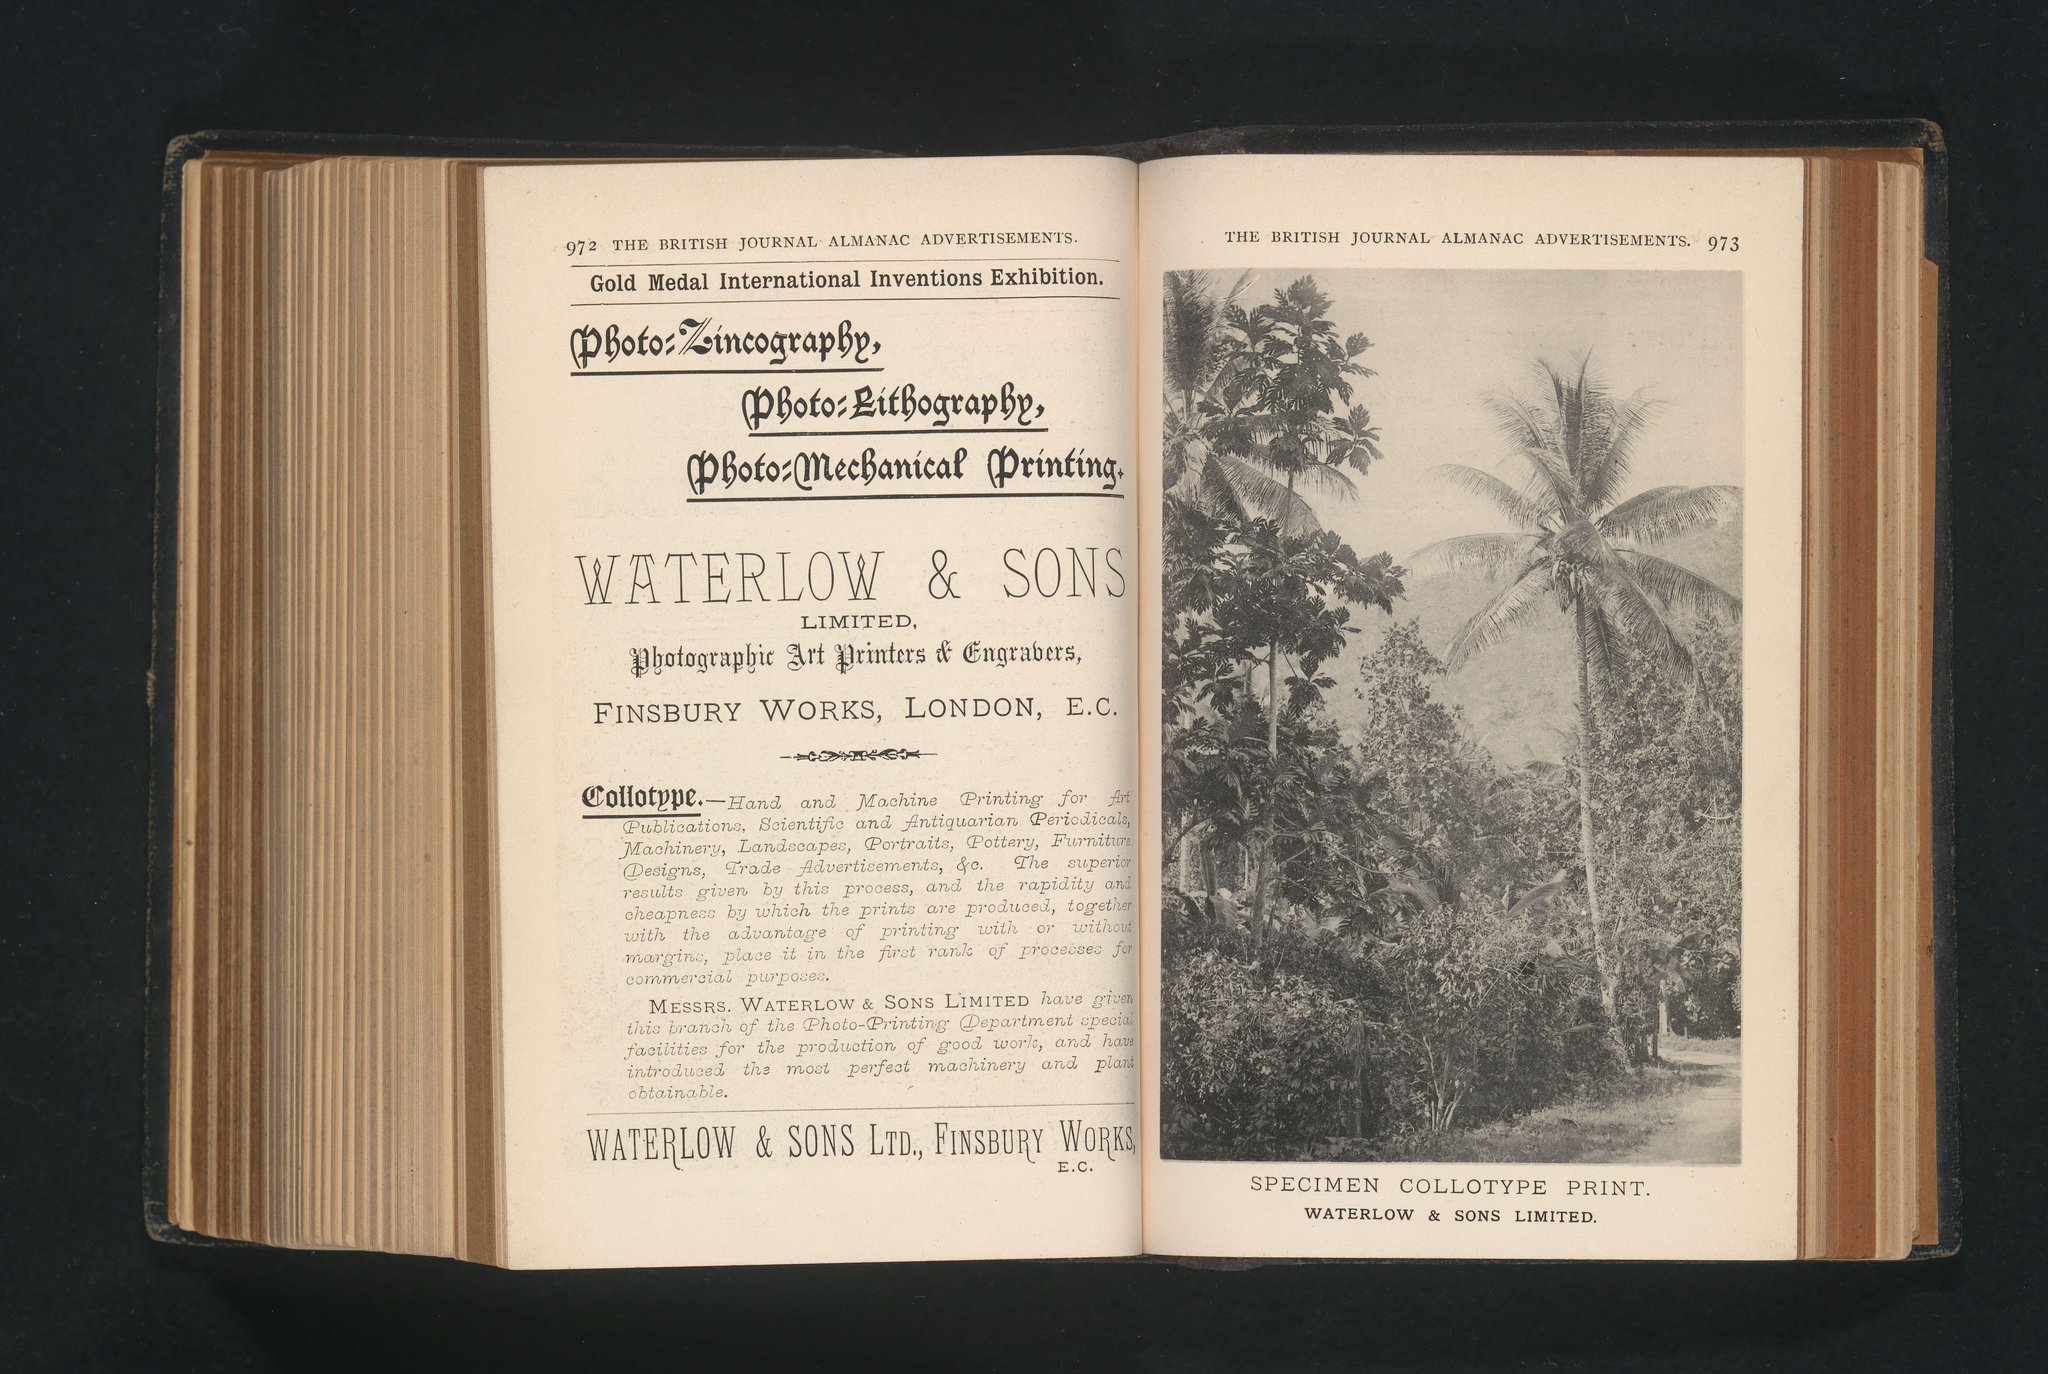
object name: photomechanical print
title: Begroeiing met palmbomen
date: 1854-1861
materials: paper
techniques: photograph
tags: forest, wood, trees: palm-tree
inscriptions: inscription: ‘The British Journal Almanac Advertisements./ Specimen collotype print’